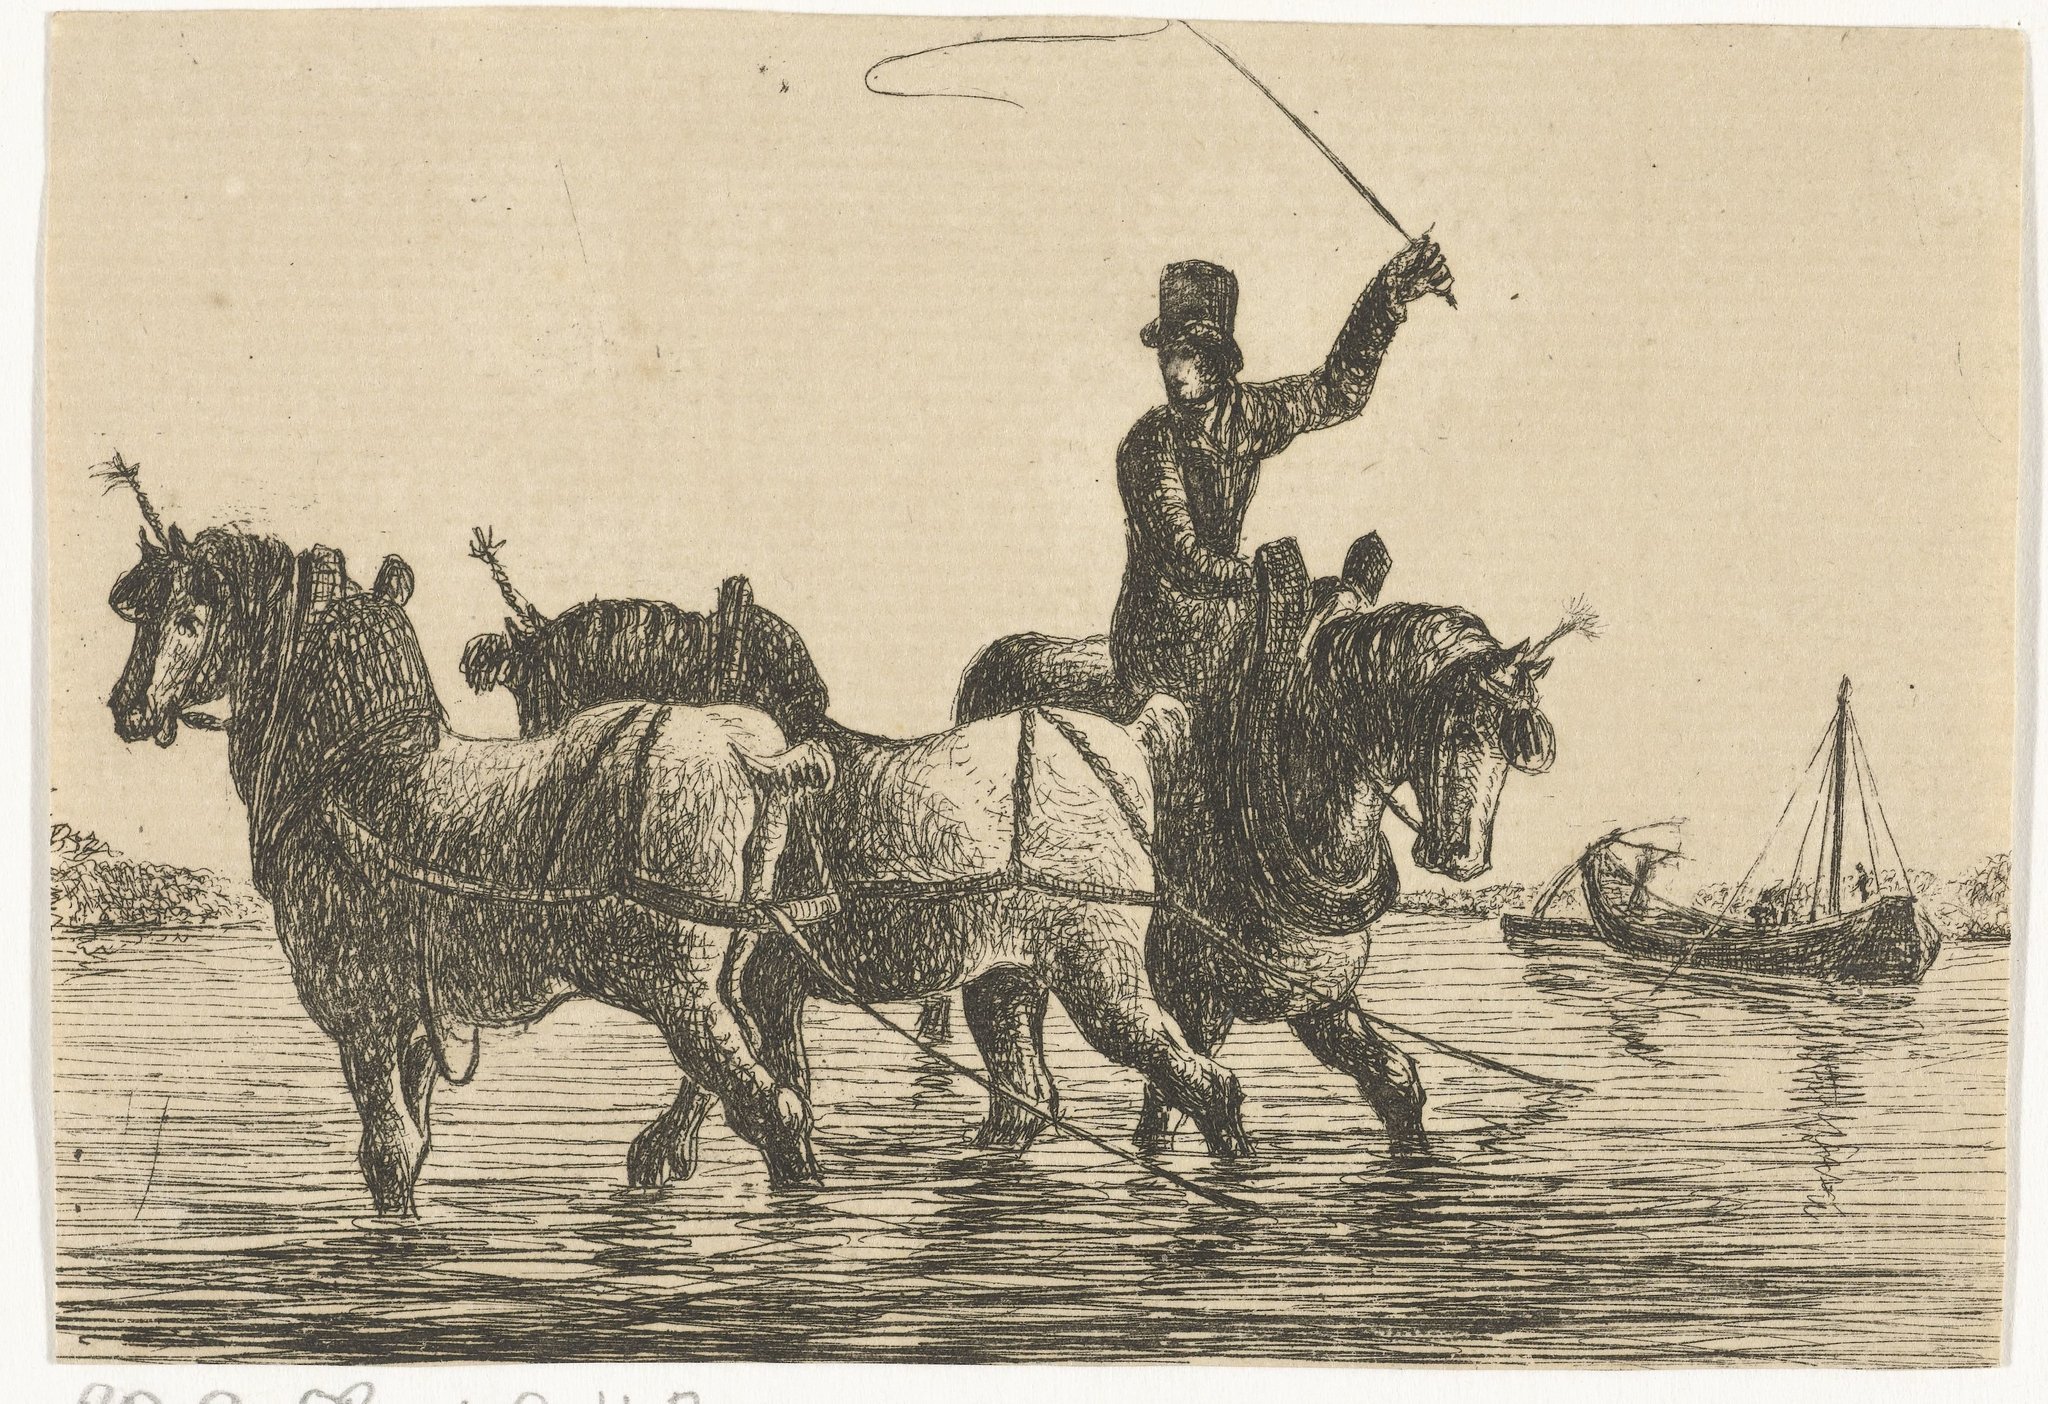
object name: print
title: Drie trekpaarden in het water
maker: otto baron howen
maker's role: draughtsman, print maker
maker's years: 1774-1848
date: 1784-1848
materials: paper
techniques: etching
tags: horse (+ traffic on the water)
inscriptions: collector's mark: Lugt 2228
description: Drie trekpaarden in het water, waarvan een wordt bereden. Rechtsachter een trekschuit.